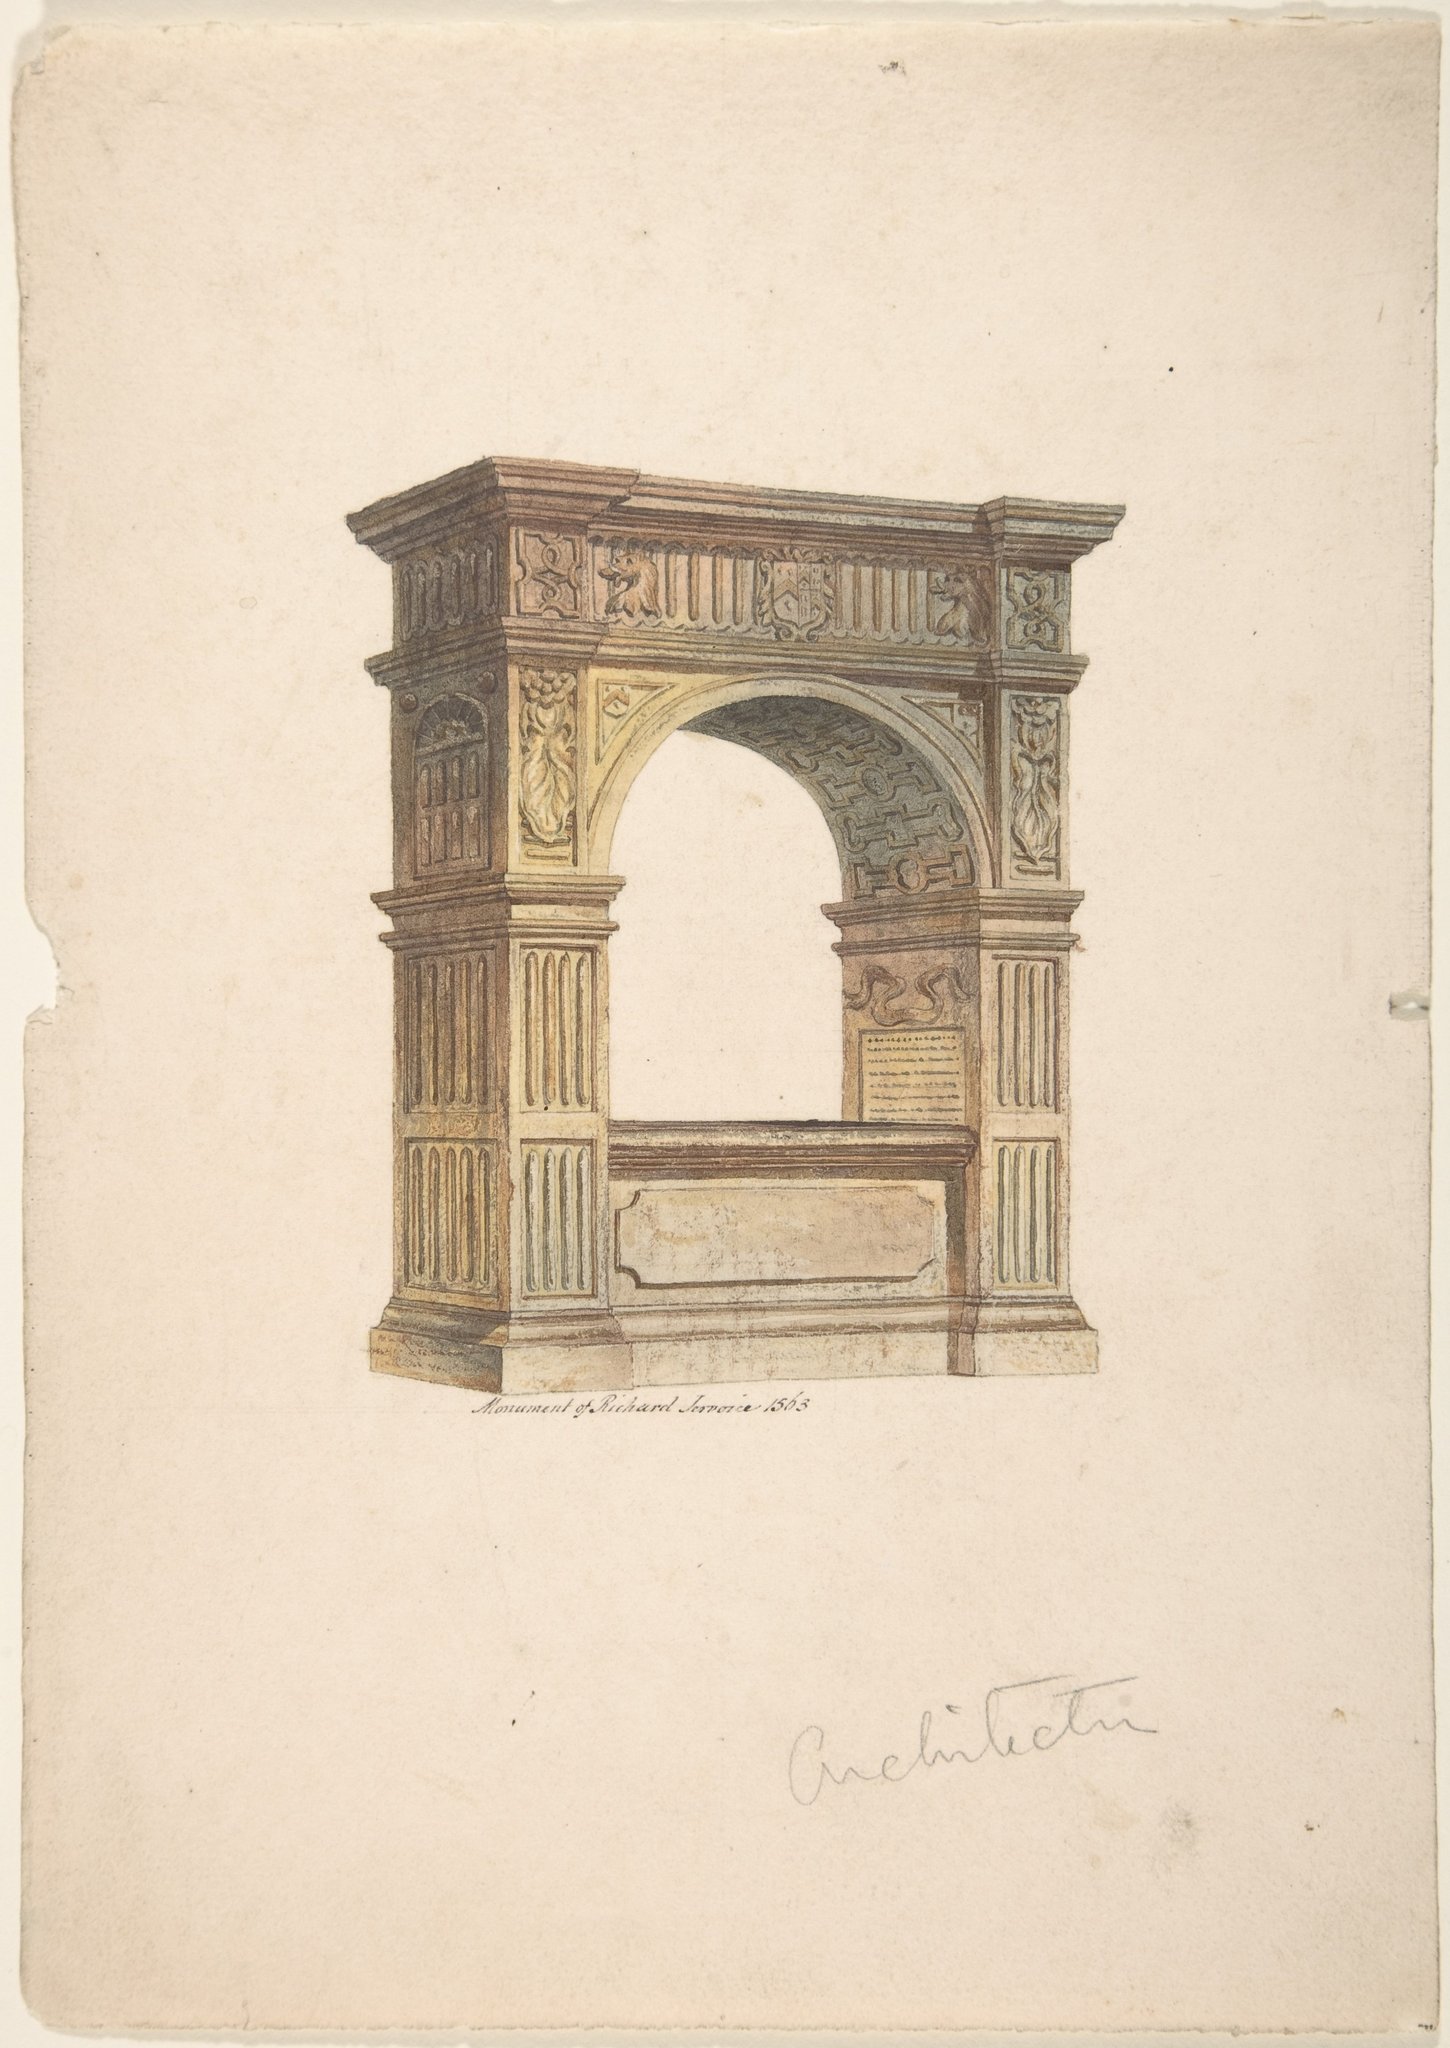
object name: drawing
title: Monument of Richard Jervoice, 1563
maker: anonymous, british, 19th century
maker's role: artist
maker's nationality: british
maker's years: 1800-1900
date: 1801-1900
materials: ink, watercolor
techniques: brush, pen, wash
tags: arches,monuments